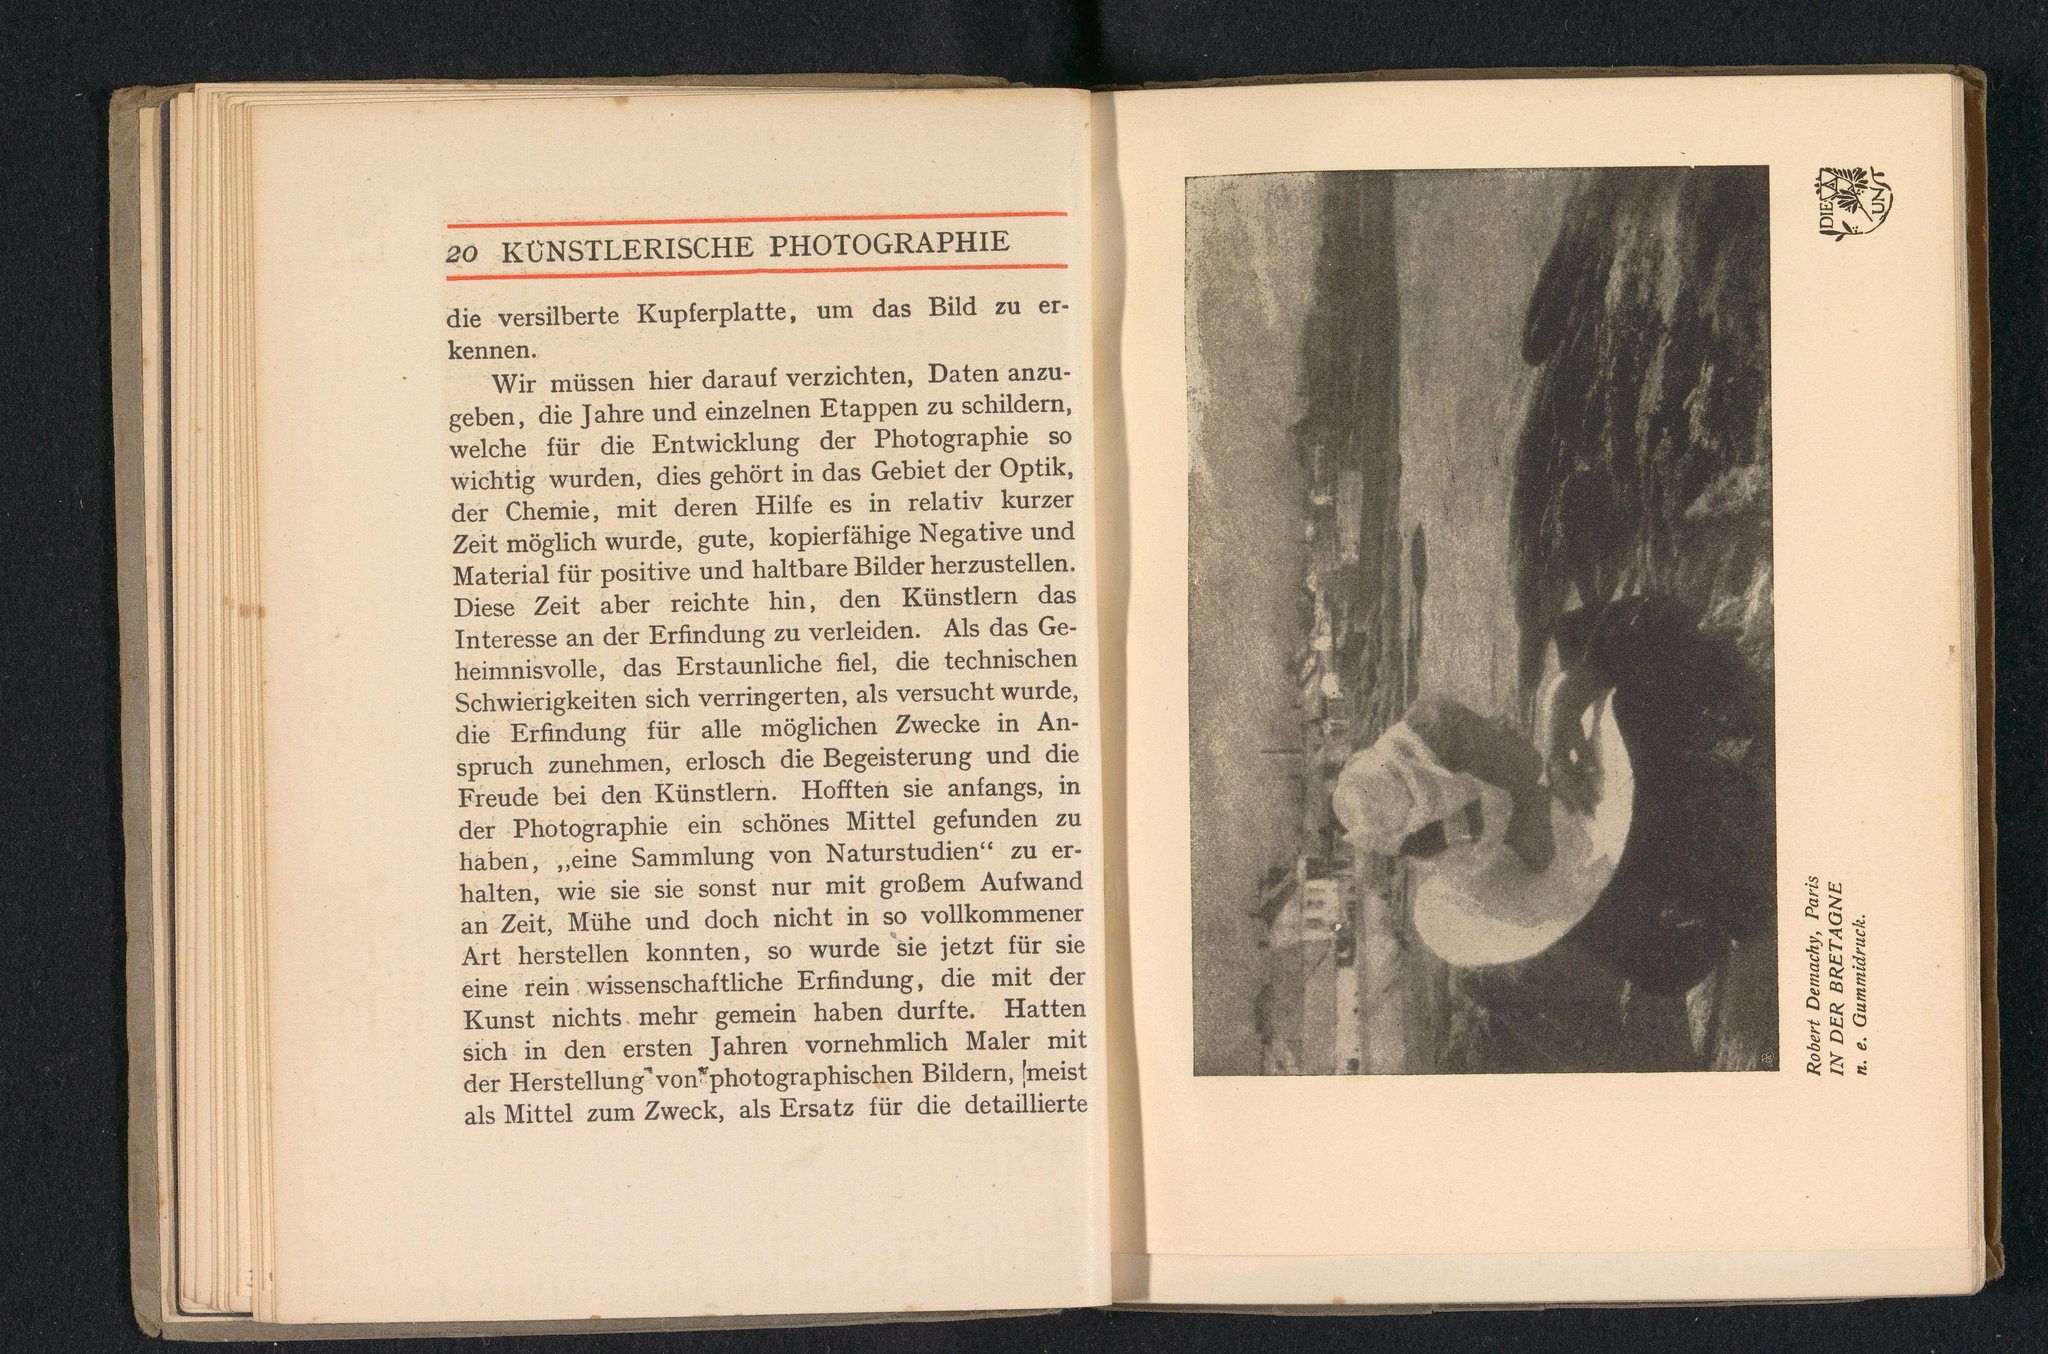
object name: photomechanical print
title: Fotoreproductie van een foto door Robert Demachy, voorstellend een vrouw aan de kust in Bretagne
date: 1880-1907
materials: paper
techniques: autotype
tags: coast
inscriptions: inscription: ‘n.e. Gummidruck.’